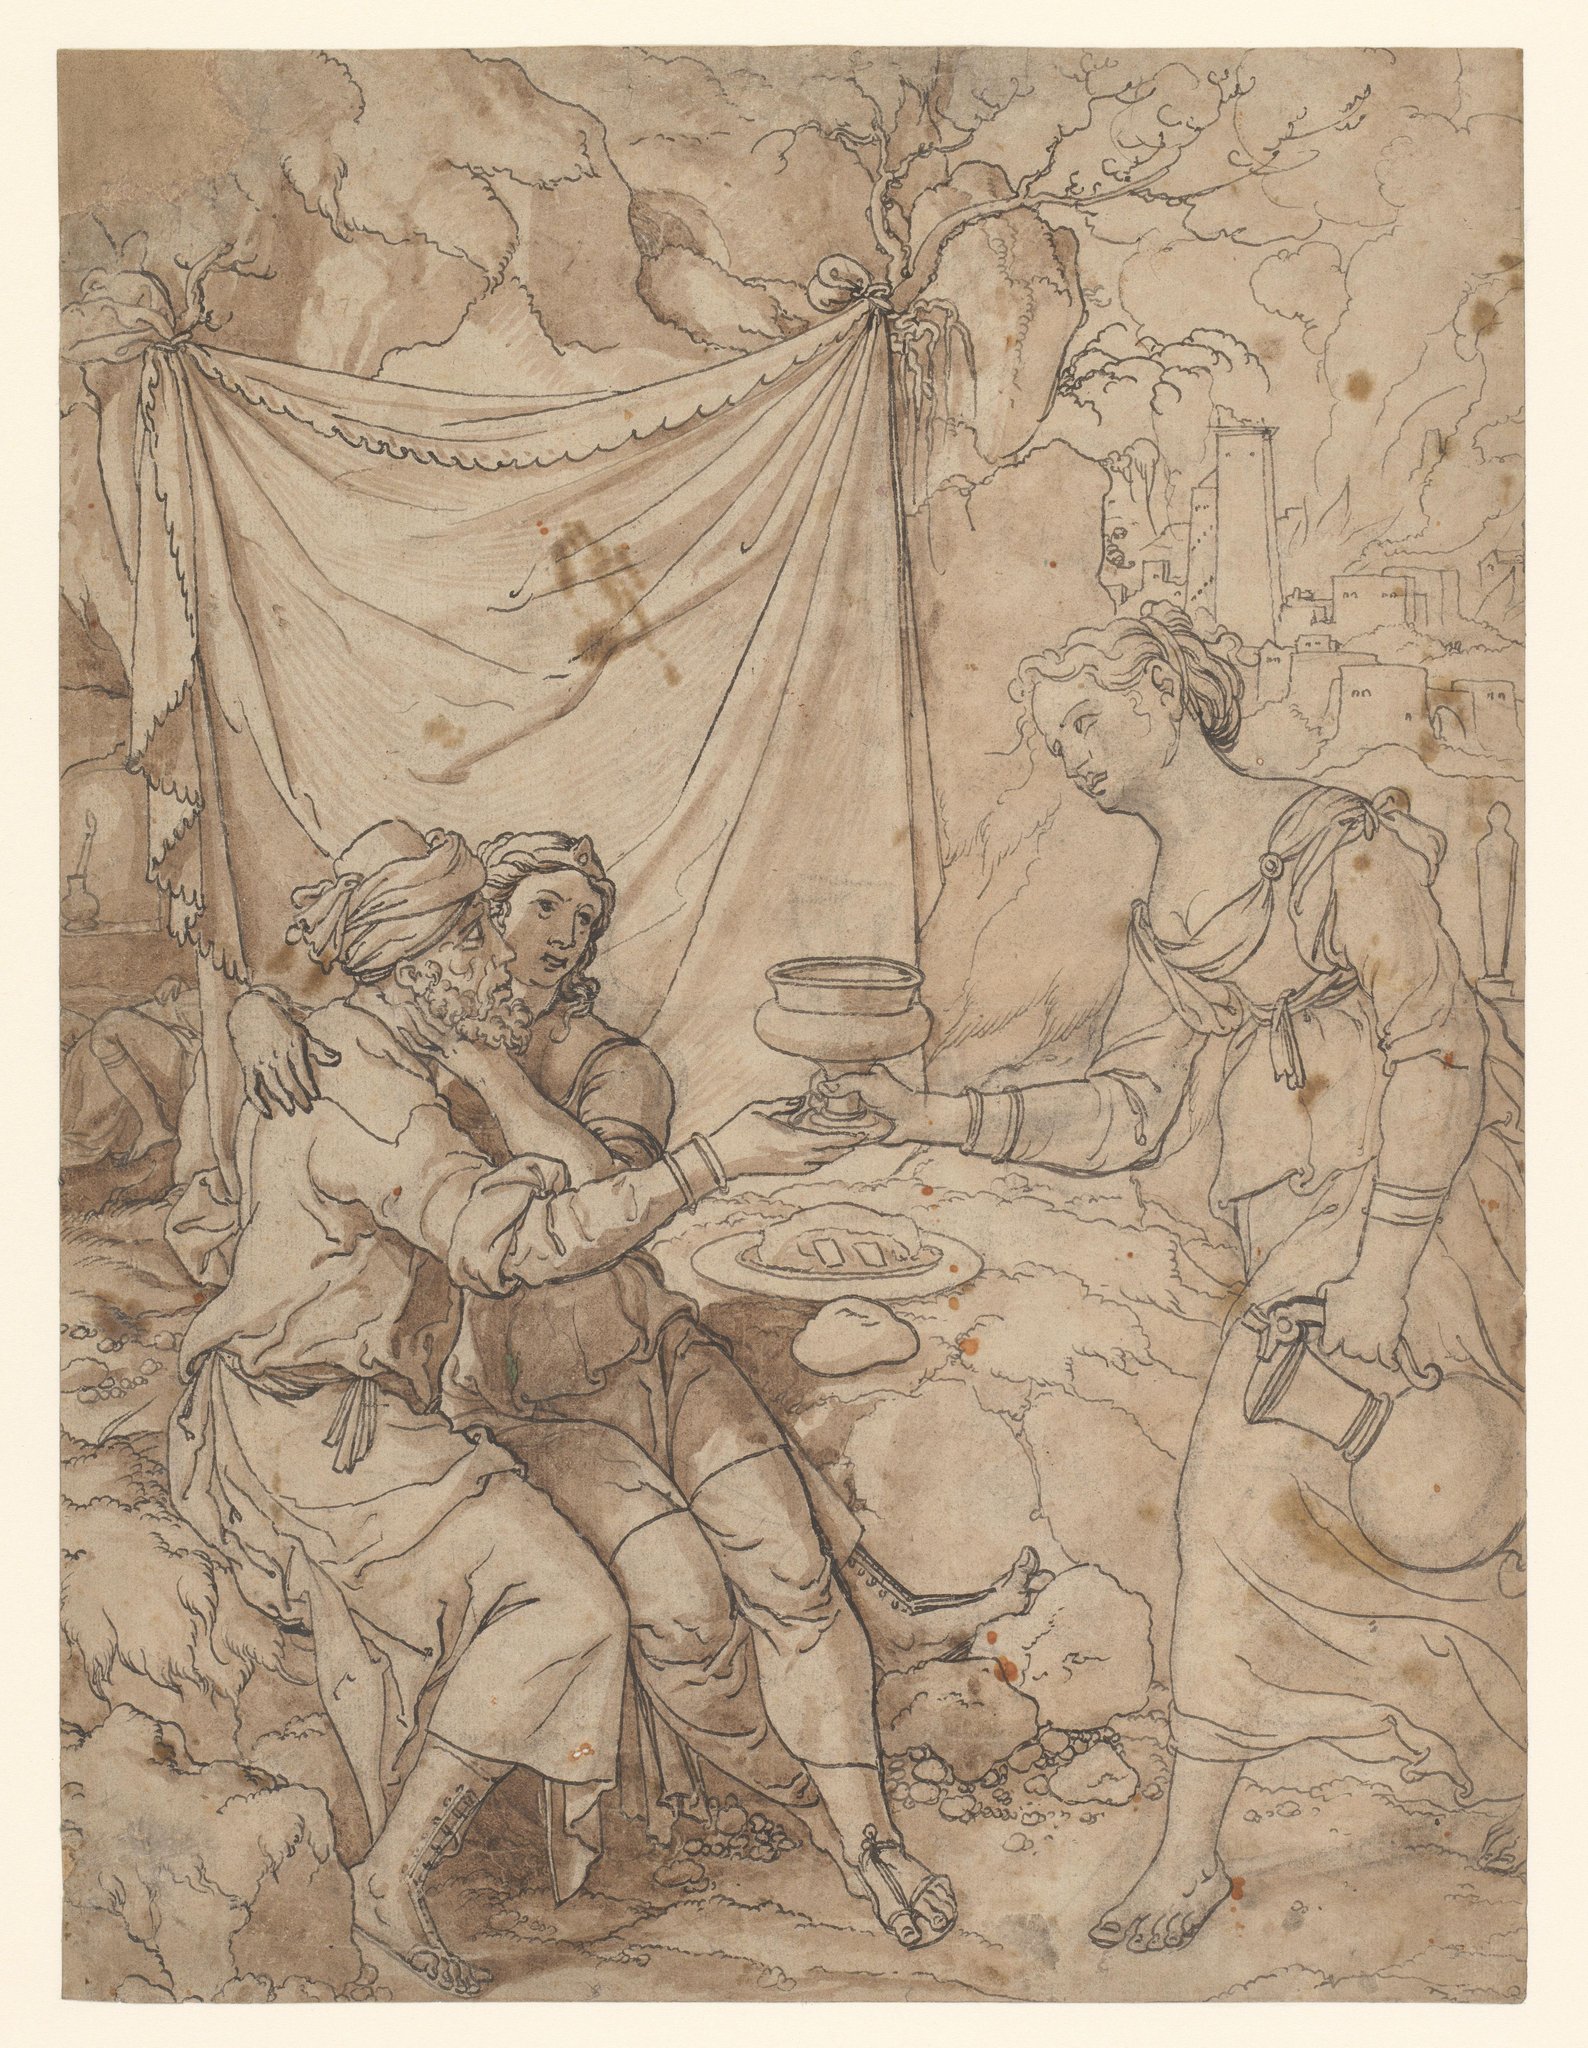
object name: design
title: Lot en zijn dochters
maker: jan swart van groningen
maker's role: draughtsman, painter, print maker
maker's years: 1500-1562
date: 1535-1560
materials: chalk, ink, paint, paper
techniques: brush, pen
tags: lot and his daughters (genesis 19:30-38)